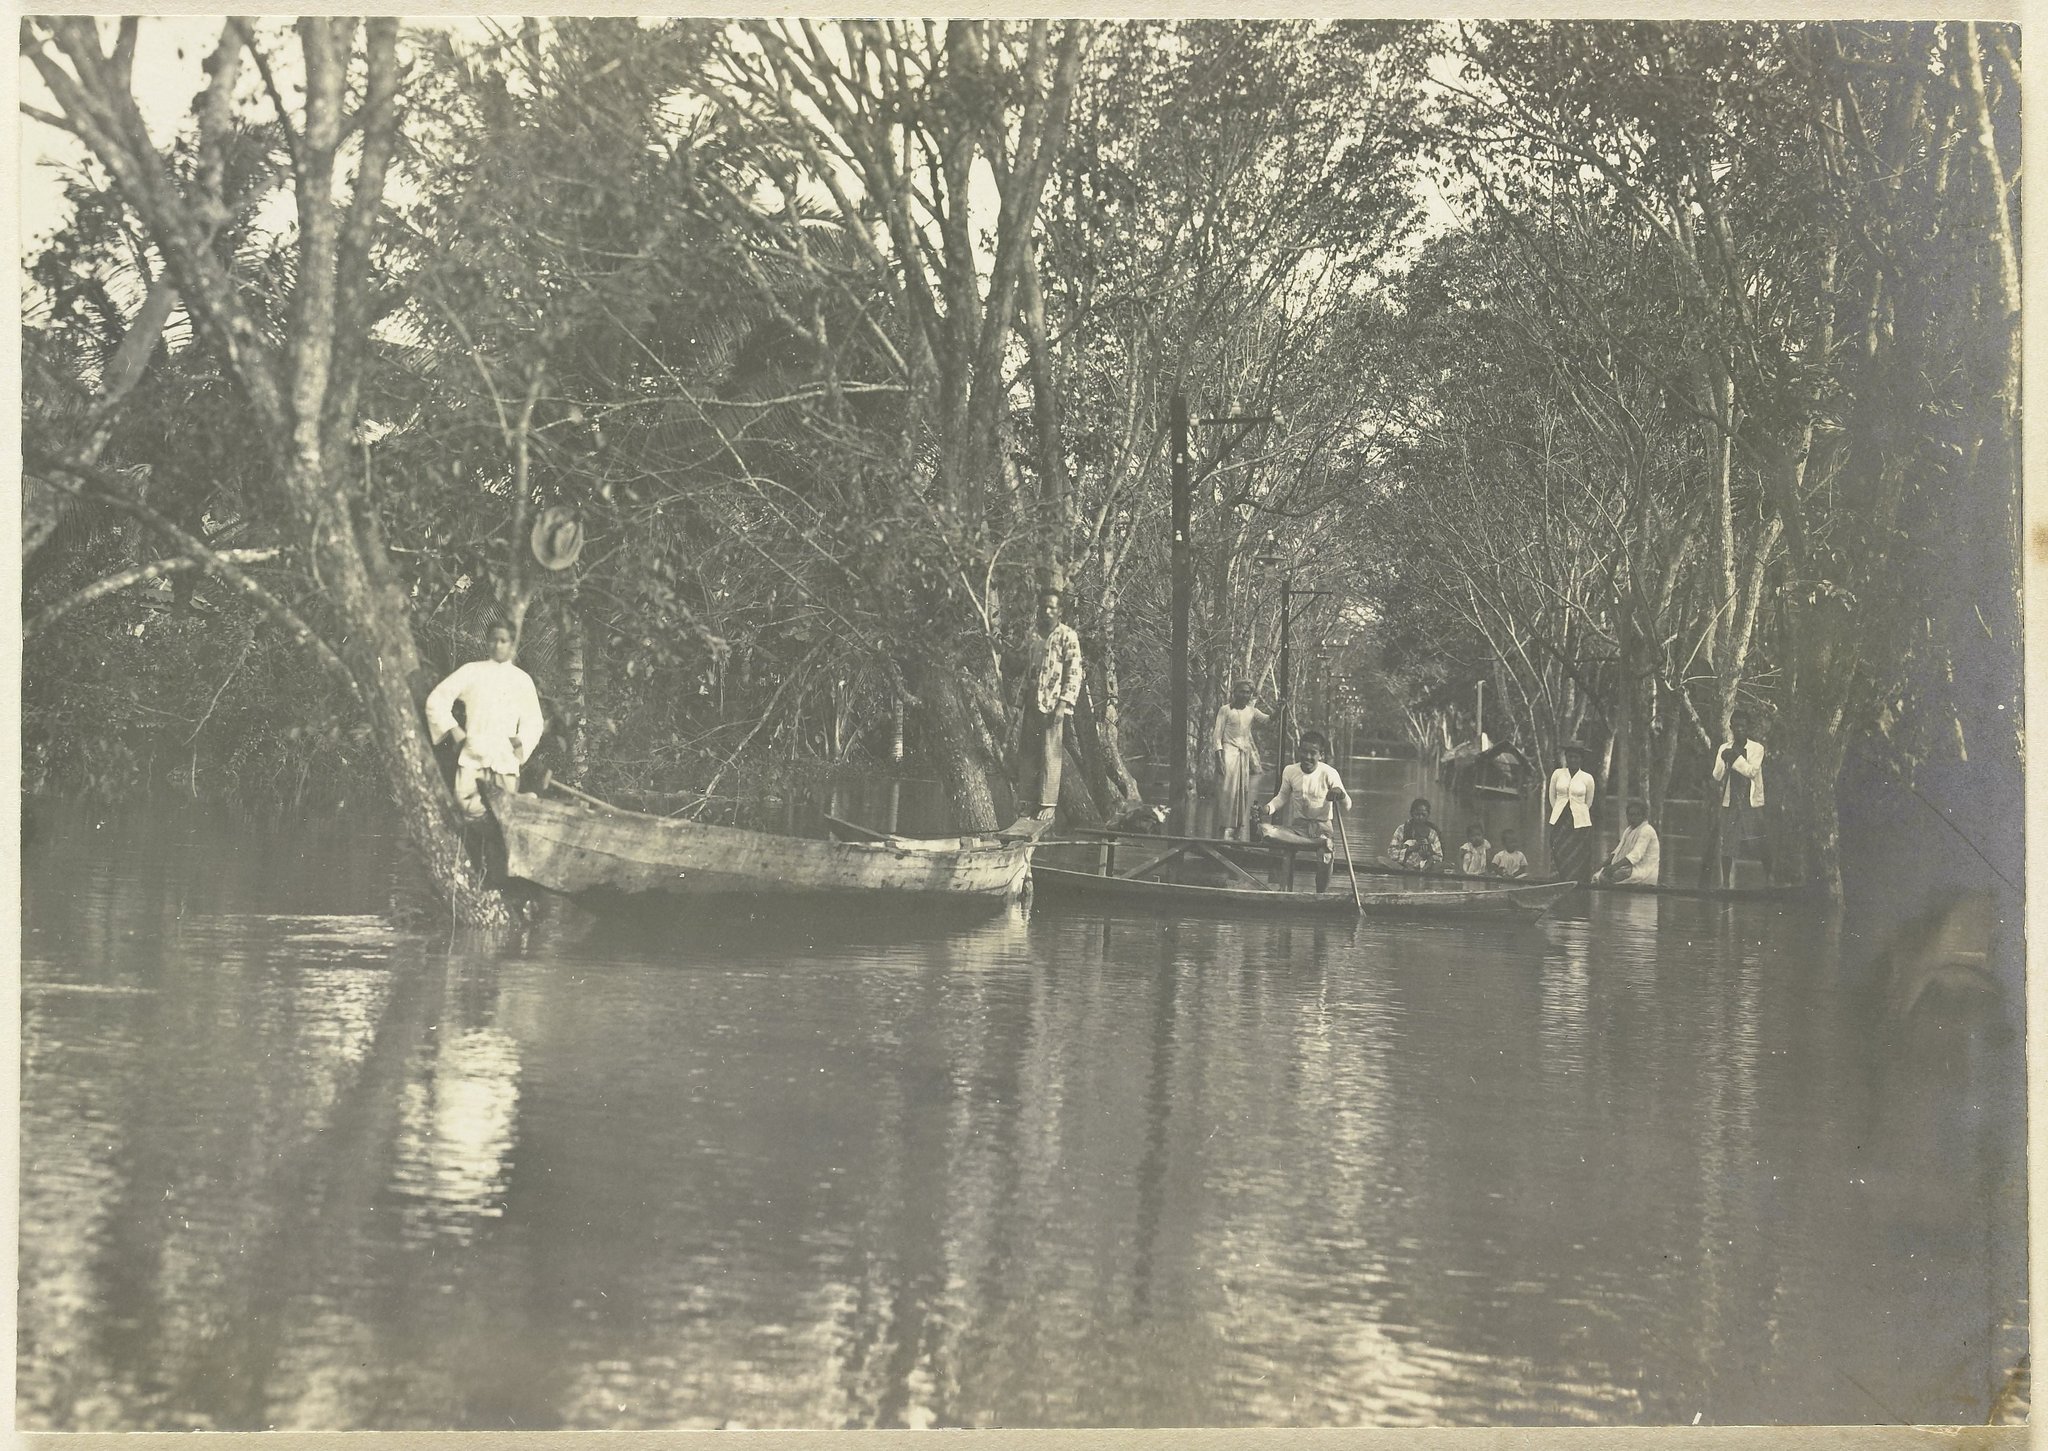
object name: photograph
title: Bootjes voeren door de overstroomde straten van Banjir, Langkat Sumatra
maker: Anonymous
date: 1900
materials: cardboard, paper, photographic support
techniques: gelatin silver print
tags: sumatra